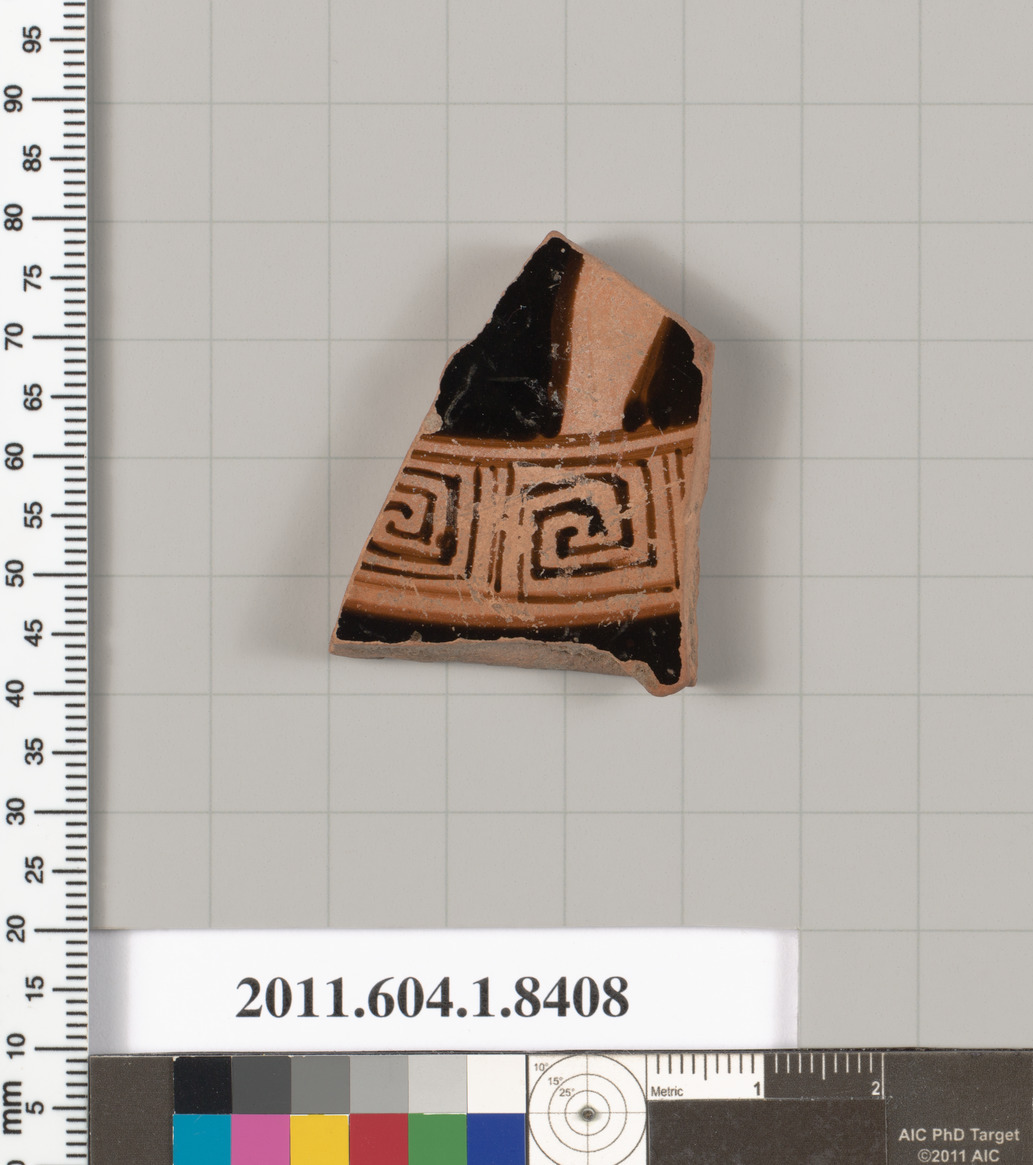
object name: kylix fragment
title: Terracotta fragment of a kylix (drinking cup)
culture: greek, attic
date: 400-351 BCE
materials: terracotta